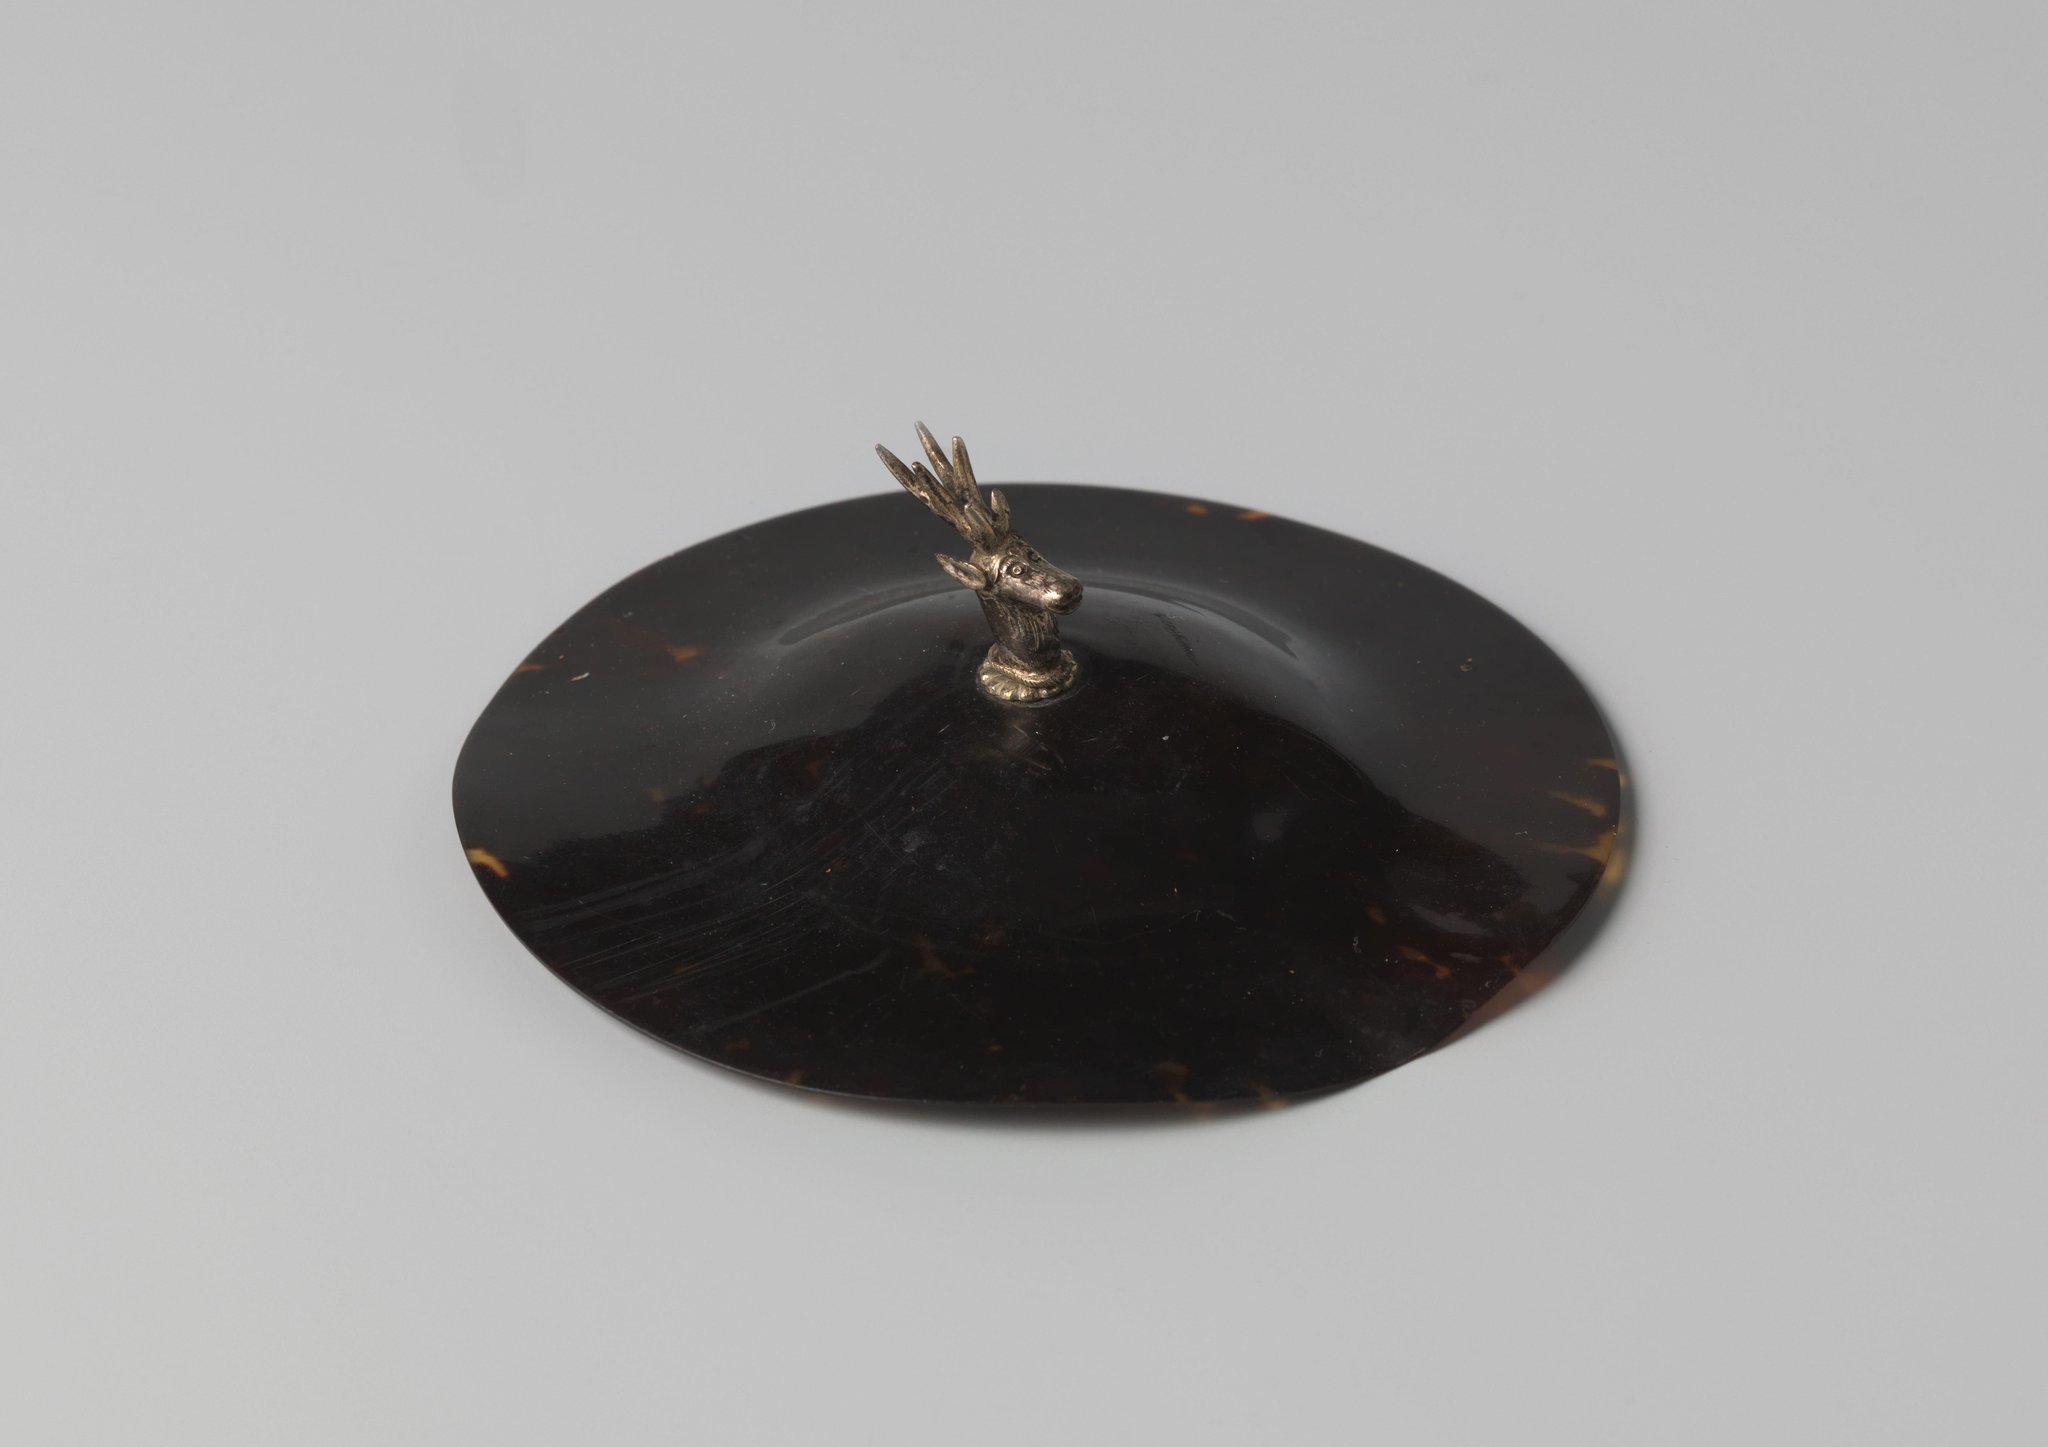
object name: schildpaddeksel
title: Deksel van schildpad met hertekop van zilver (serie van 28 stuks A t/m BB)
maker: Anonymous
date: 1700-1799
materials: silver, shell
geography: indonesia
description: Schildpad-deksel (28 stuks: A t/m BB) met hertekop van zilver als knop.